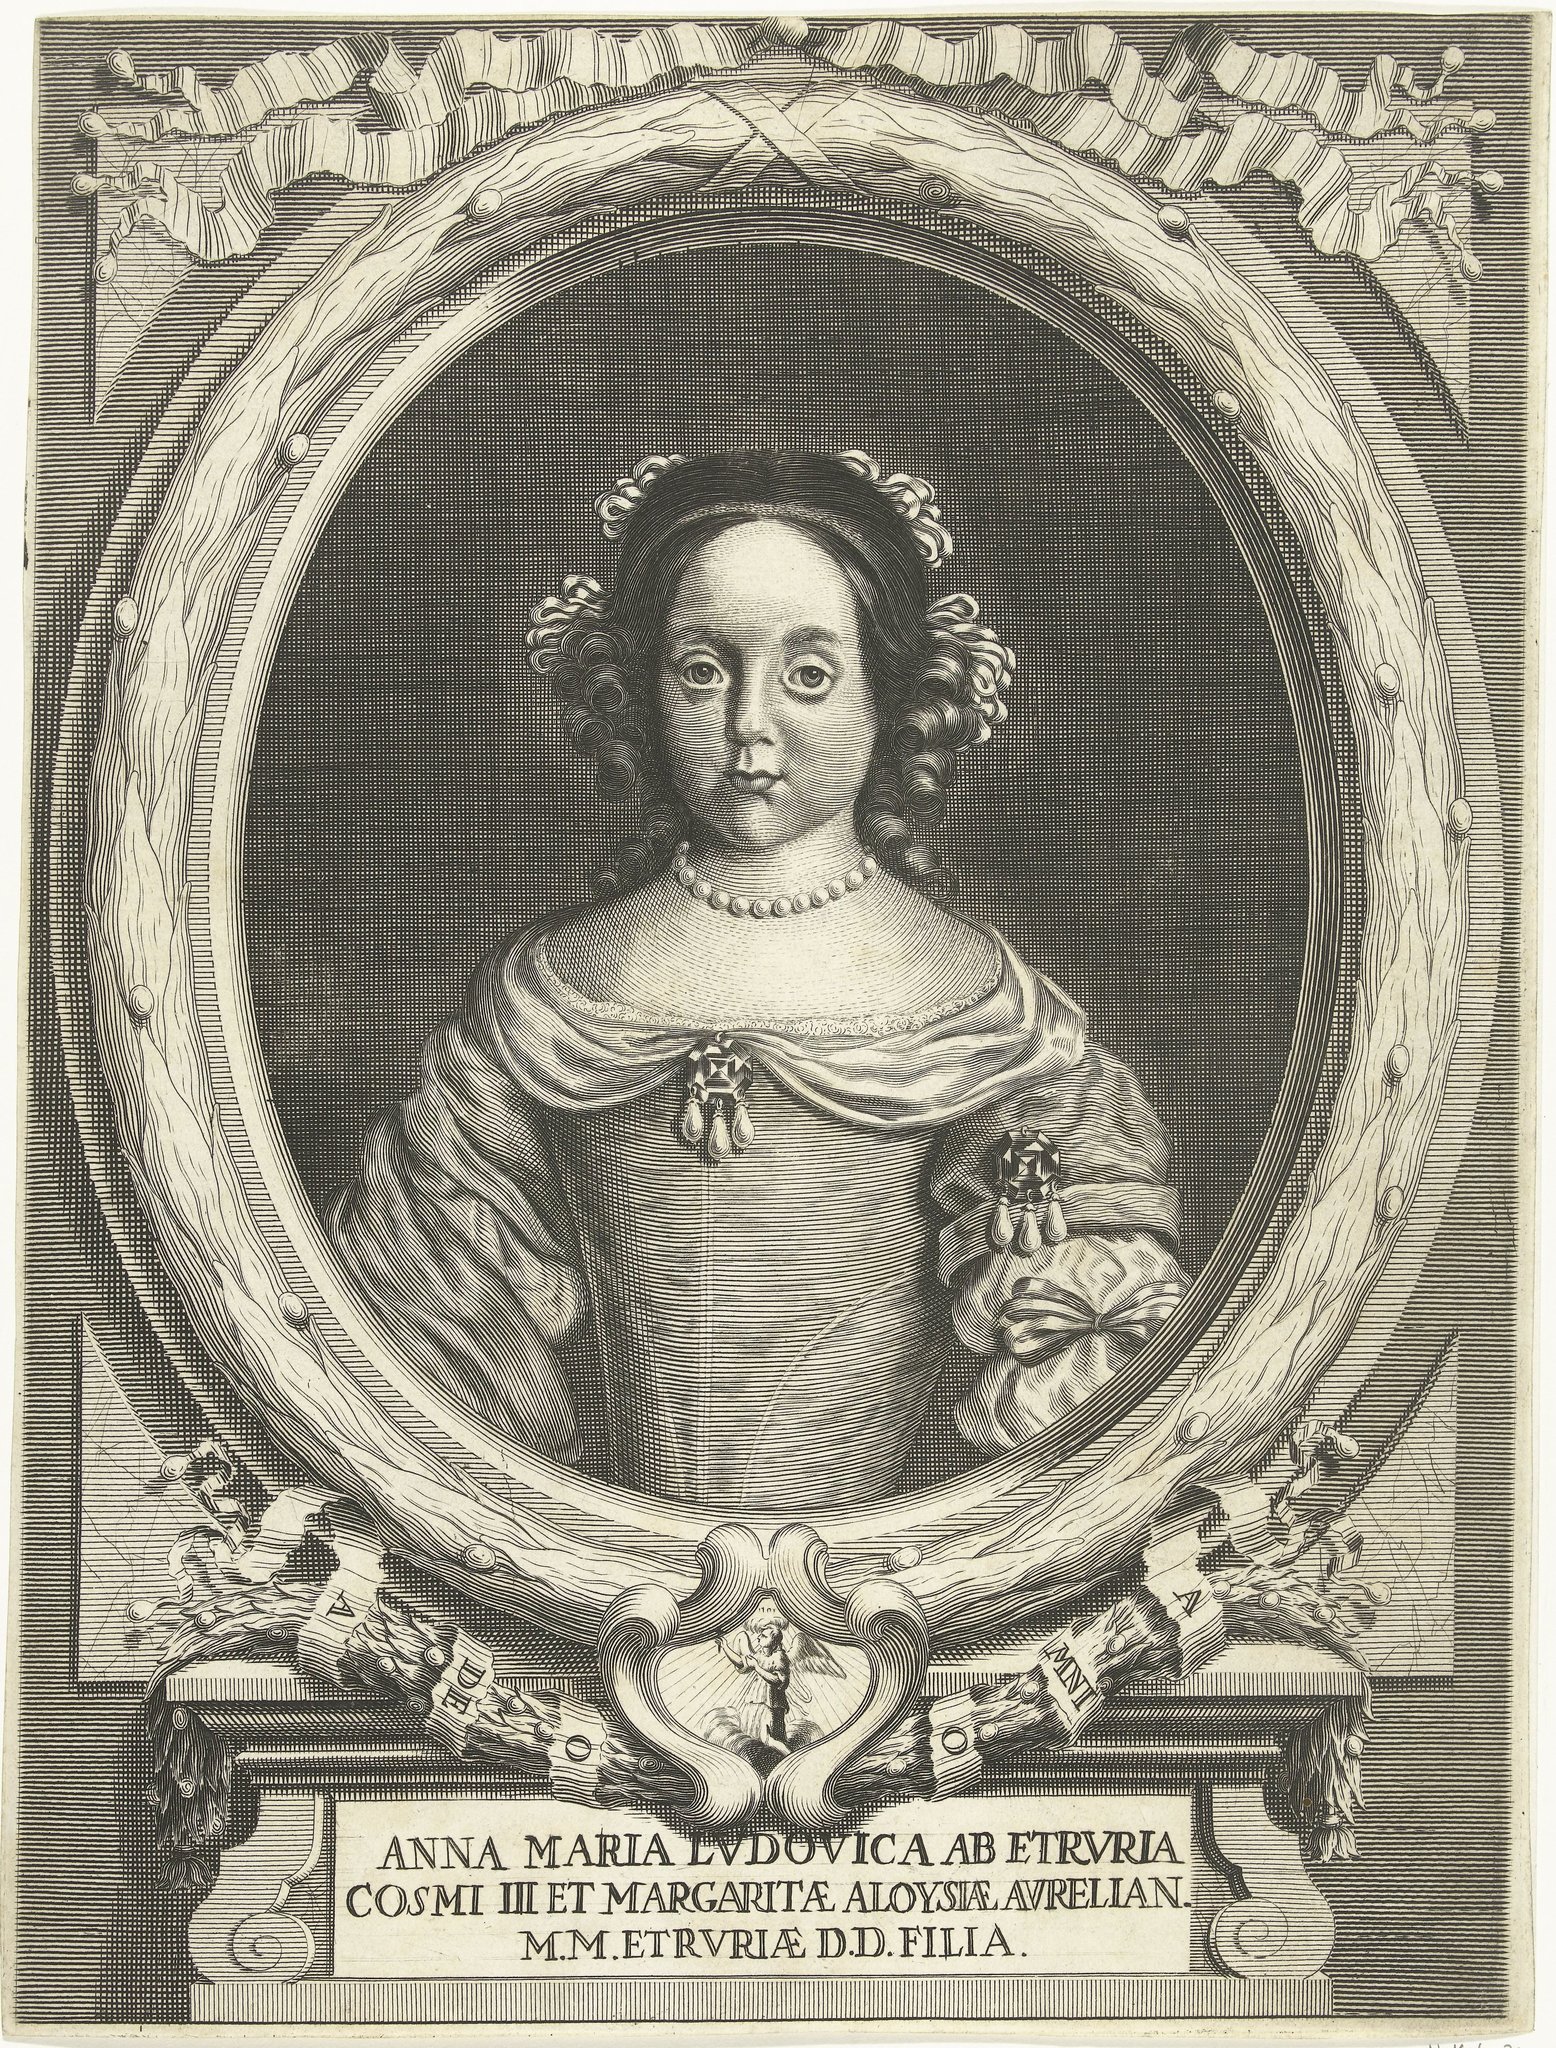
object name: print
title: Portret van Anna Maria Luisa de Medici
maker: adriaen haelwegh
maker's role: print maker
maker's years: 1637-1702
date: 1647-1696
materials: paper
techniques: engraving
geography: northern netherlands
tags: accessories (~ clothing), pearl; pearl necklace (+ women's clothes)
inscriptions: collector's mark: Lugt 2228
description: Portret ten halven lijve van Anna Maria Luisa de Medici, dochter van Cosimo III de Medici en Margaretha Louise van Orléans, in een ovaal omringd met een lauwerkrans. Onderaan in een cartouche een engel, daaronder op een tablet onder een plint haar naam en twee regels in Latijn.